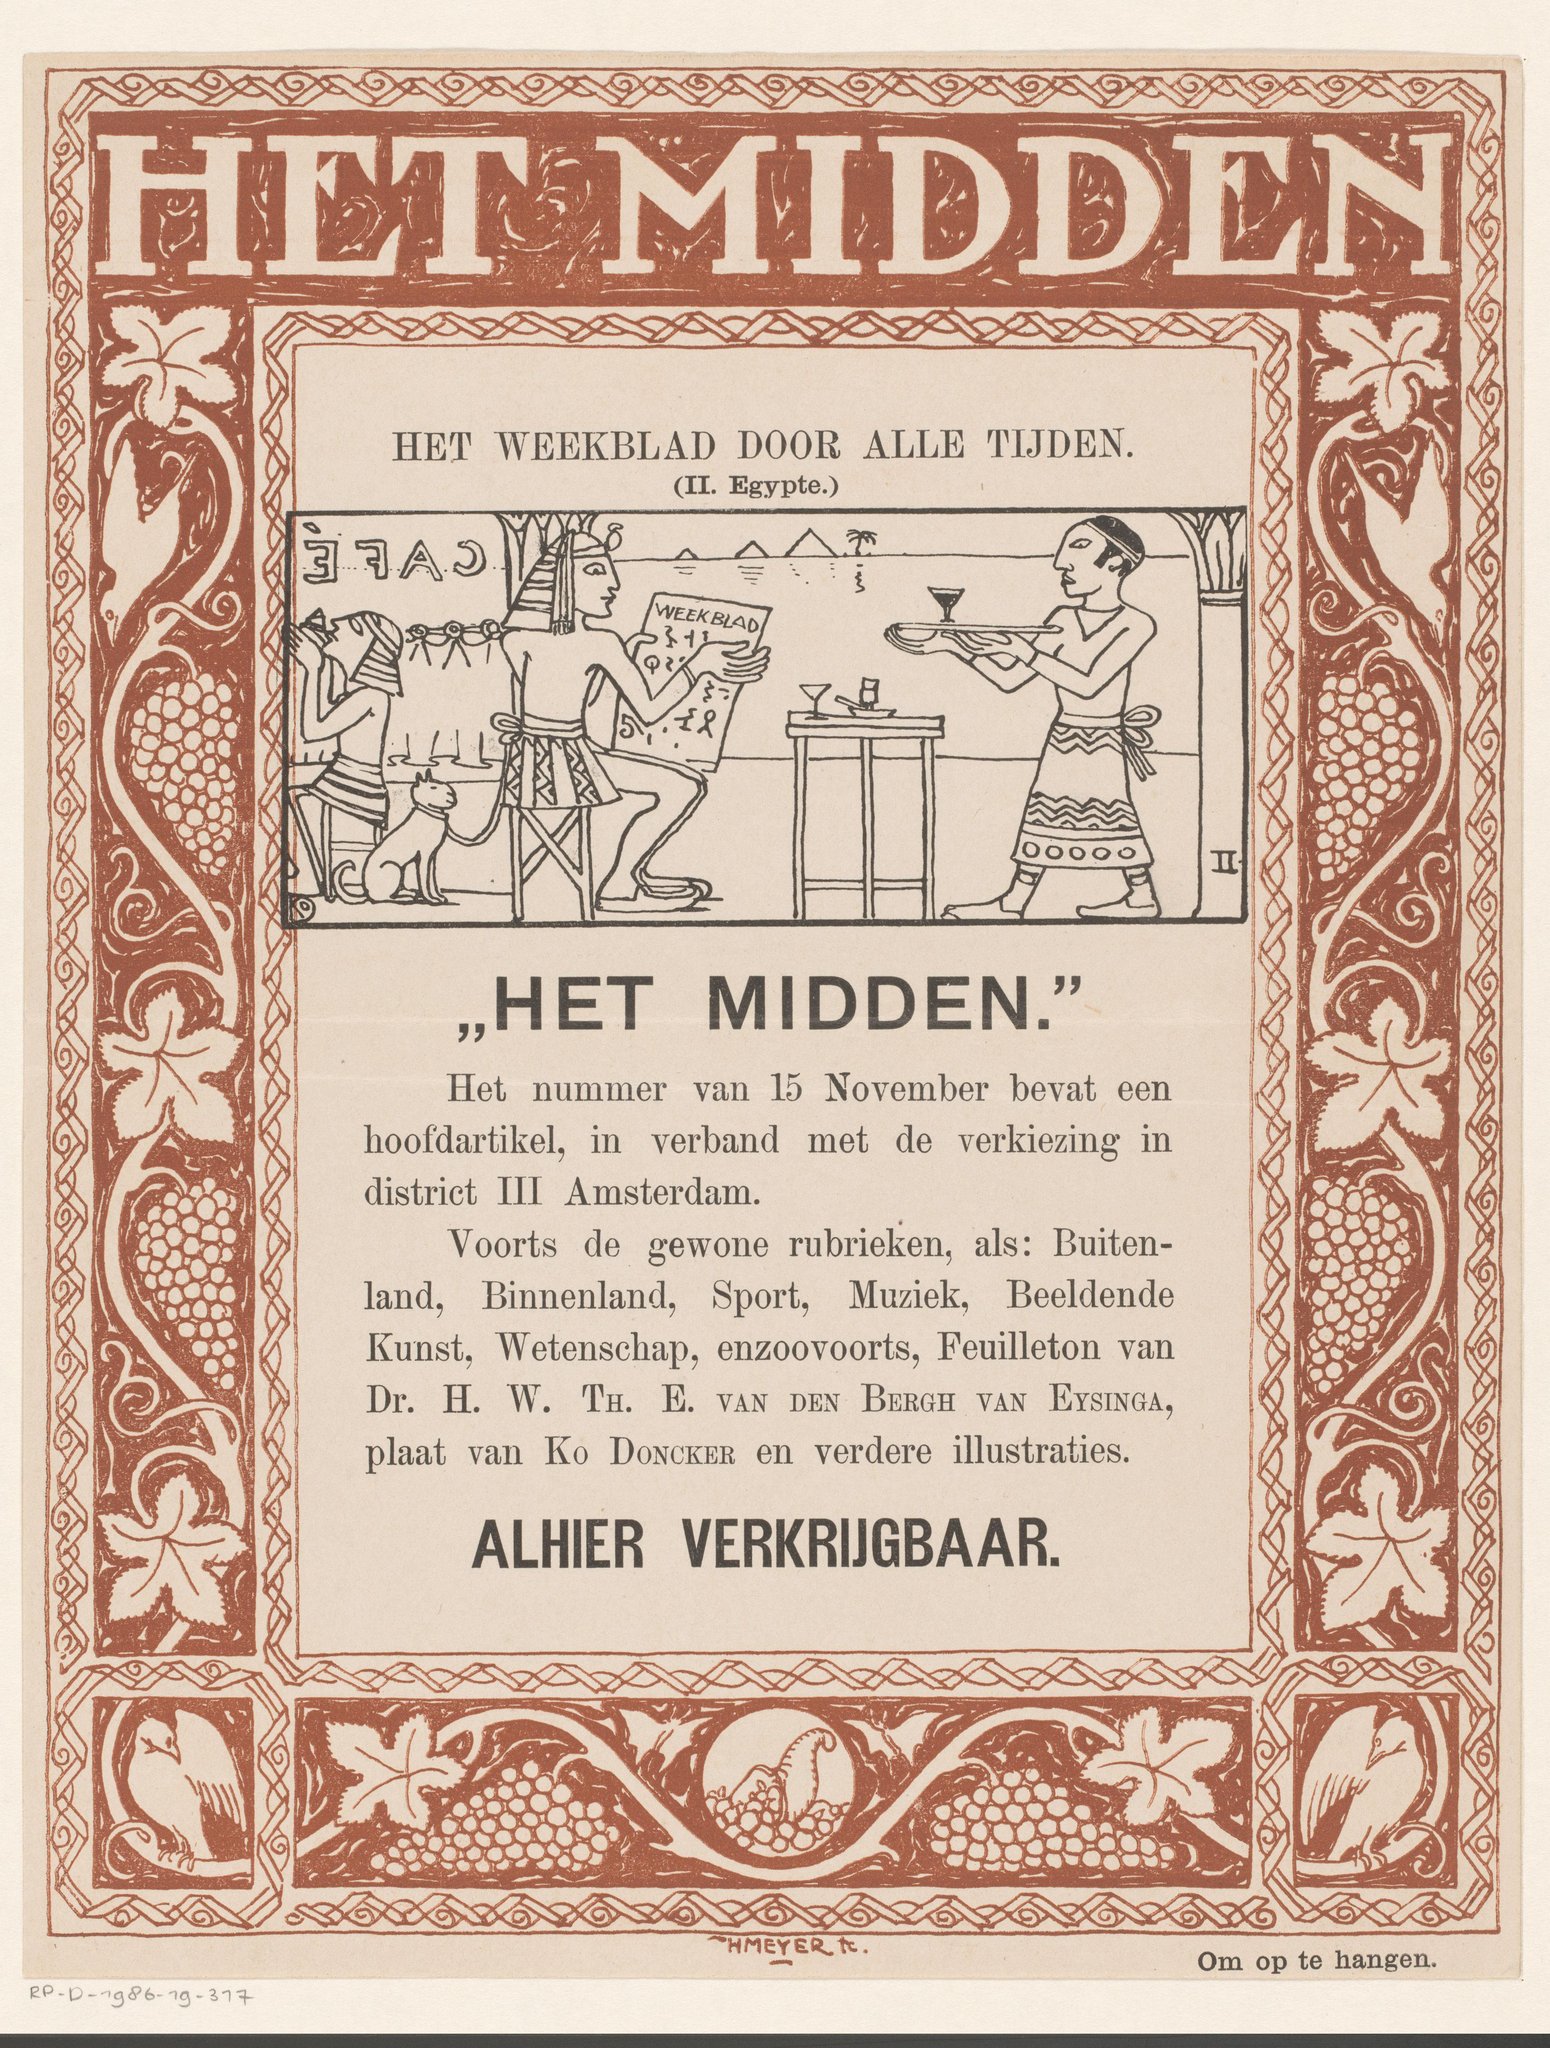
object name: photomechanical print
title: Affiche voor weekblad 'Het Midden'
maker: h. meyer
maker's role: draughtsman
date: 1849-1949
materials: paper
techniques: printing block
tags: inn, coffee-house, public house, etc., pyramid (marking grave)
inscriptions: collector's mark: ‘R:MVS.’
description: Een ober brengt een drankje naar een man die in een café weekblad 'Het Midden' zit te lezen. In de achtergrond een woestijnlandschap met piramides. De voorstelling is getekend in Egyptische stijl. Rondom de voorstelling een ornamentrand met vogels, bladeren en druiven.